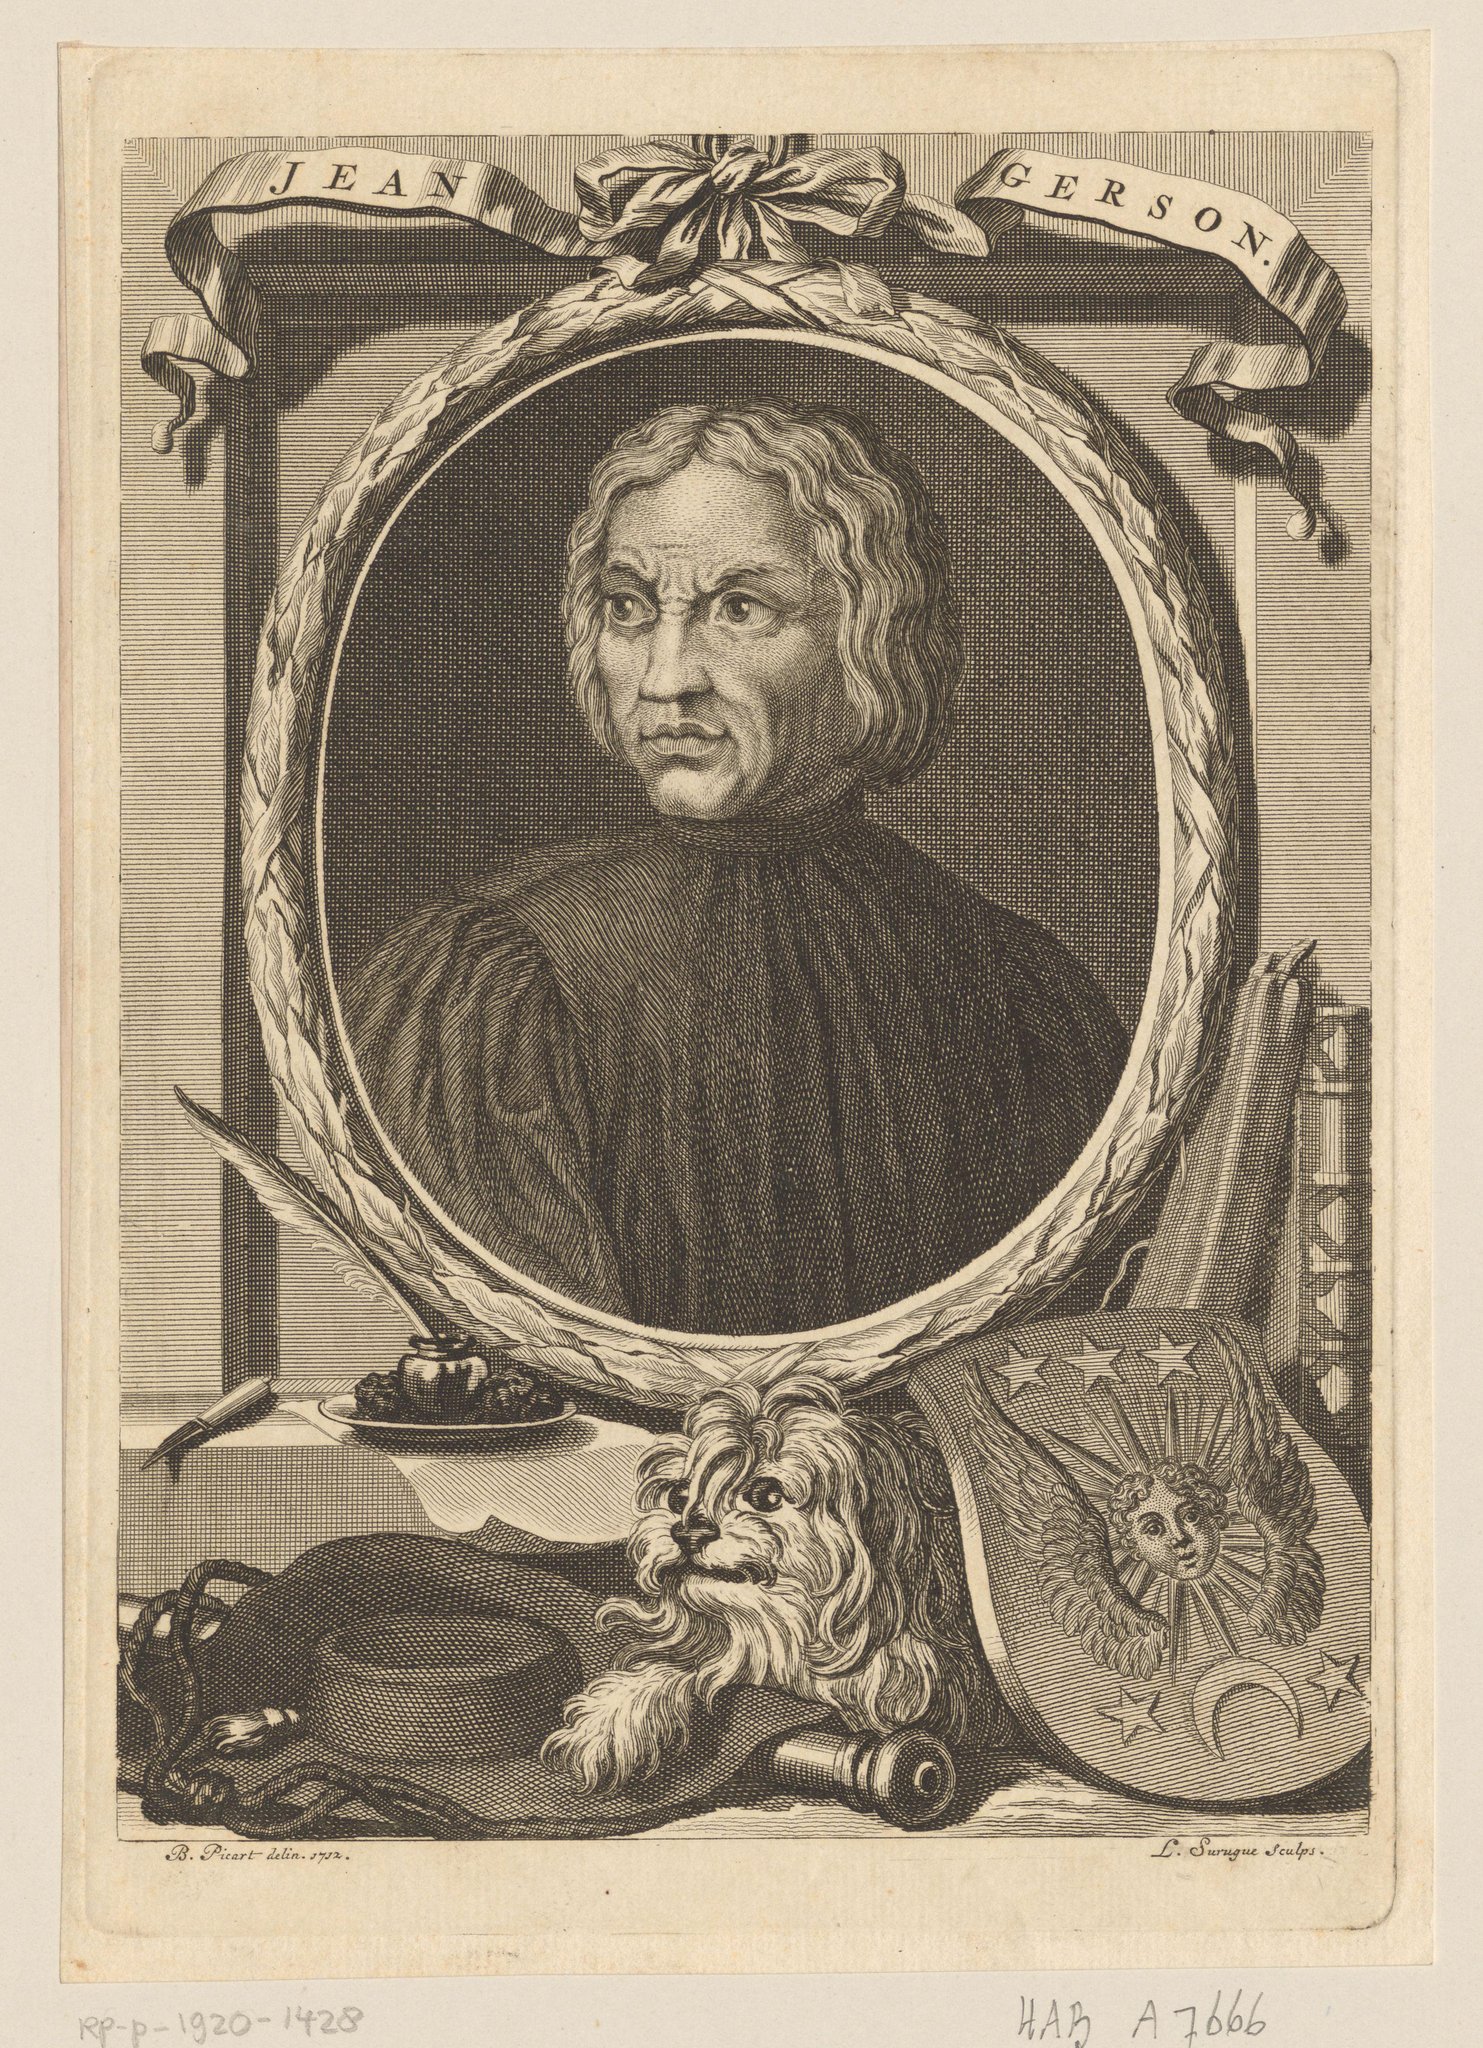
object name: print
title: Portret van Jean de Gerson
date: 1712-1762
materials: paper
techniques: engraving, etching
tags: lyon, theologian, historical persons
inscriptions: collector's mark: Lugt 2228